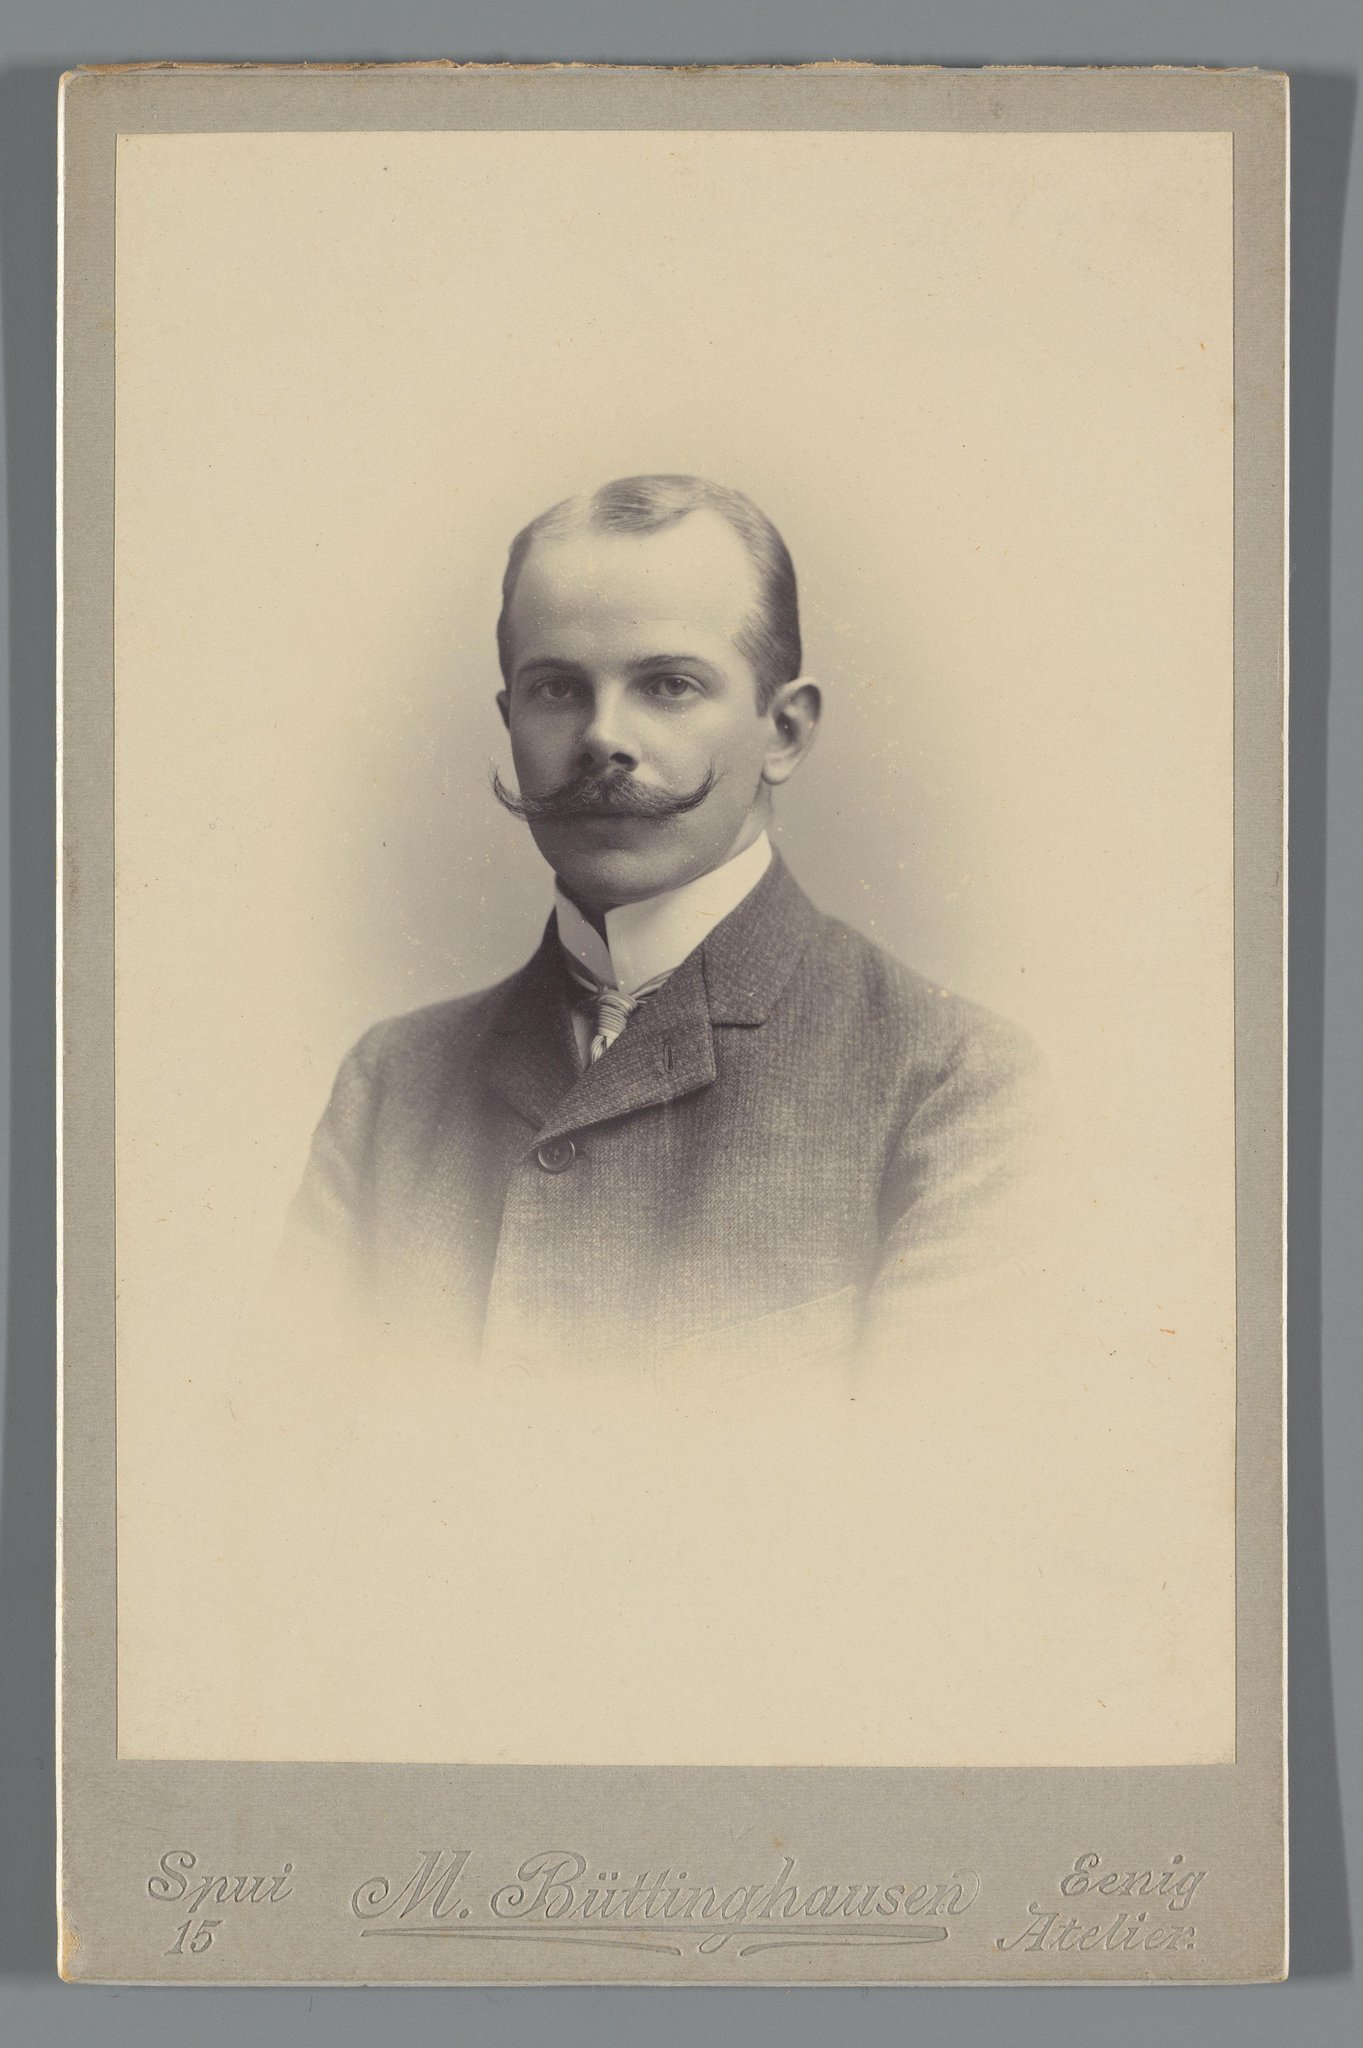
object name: cabinet photograph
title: Portret van Hendrik Herman van den Berg (Henk)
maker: max büttinghausen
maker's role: fotograaf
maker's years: 1847-1906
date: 1898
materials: cardboard, photographic support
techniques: albumen print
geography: spui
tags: batavia, amsterdam, hendrik herman van den berg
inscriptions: inscription: ‘Vader ±1898’, inscription: ‘Spui / 15 / M. Büttinghausen AMSTERDAM / Eenig / Atelier.’